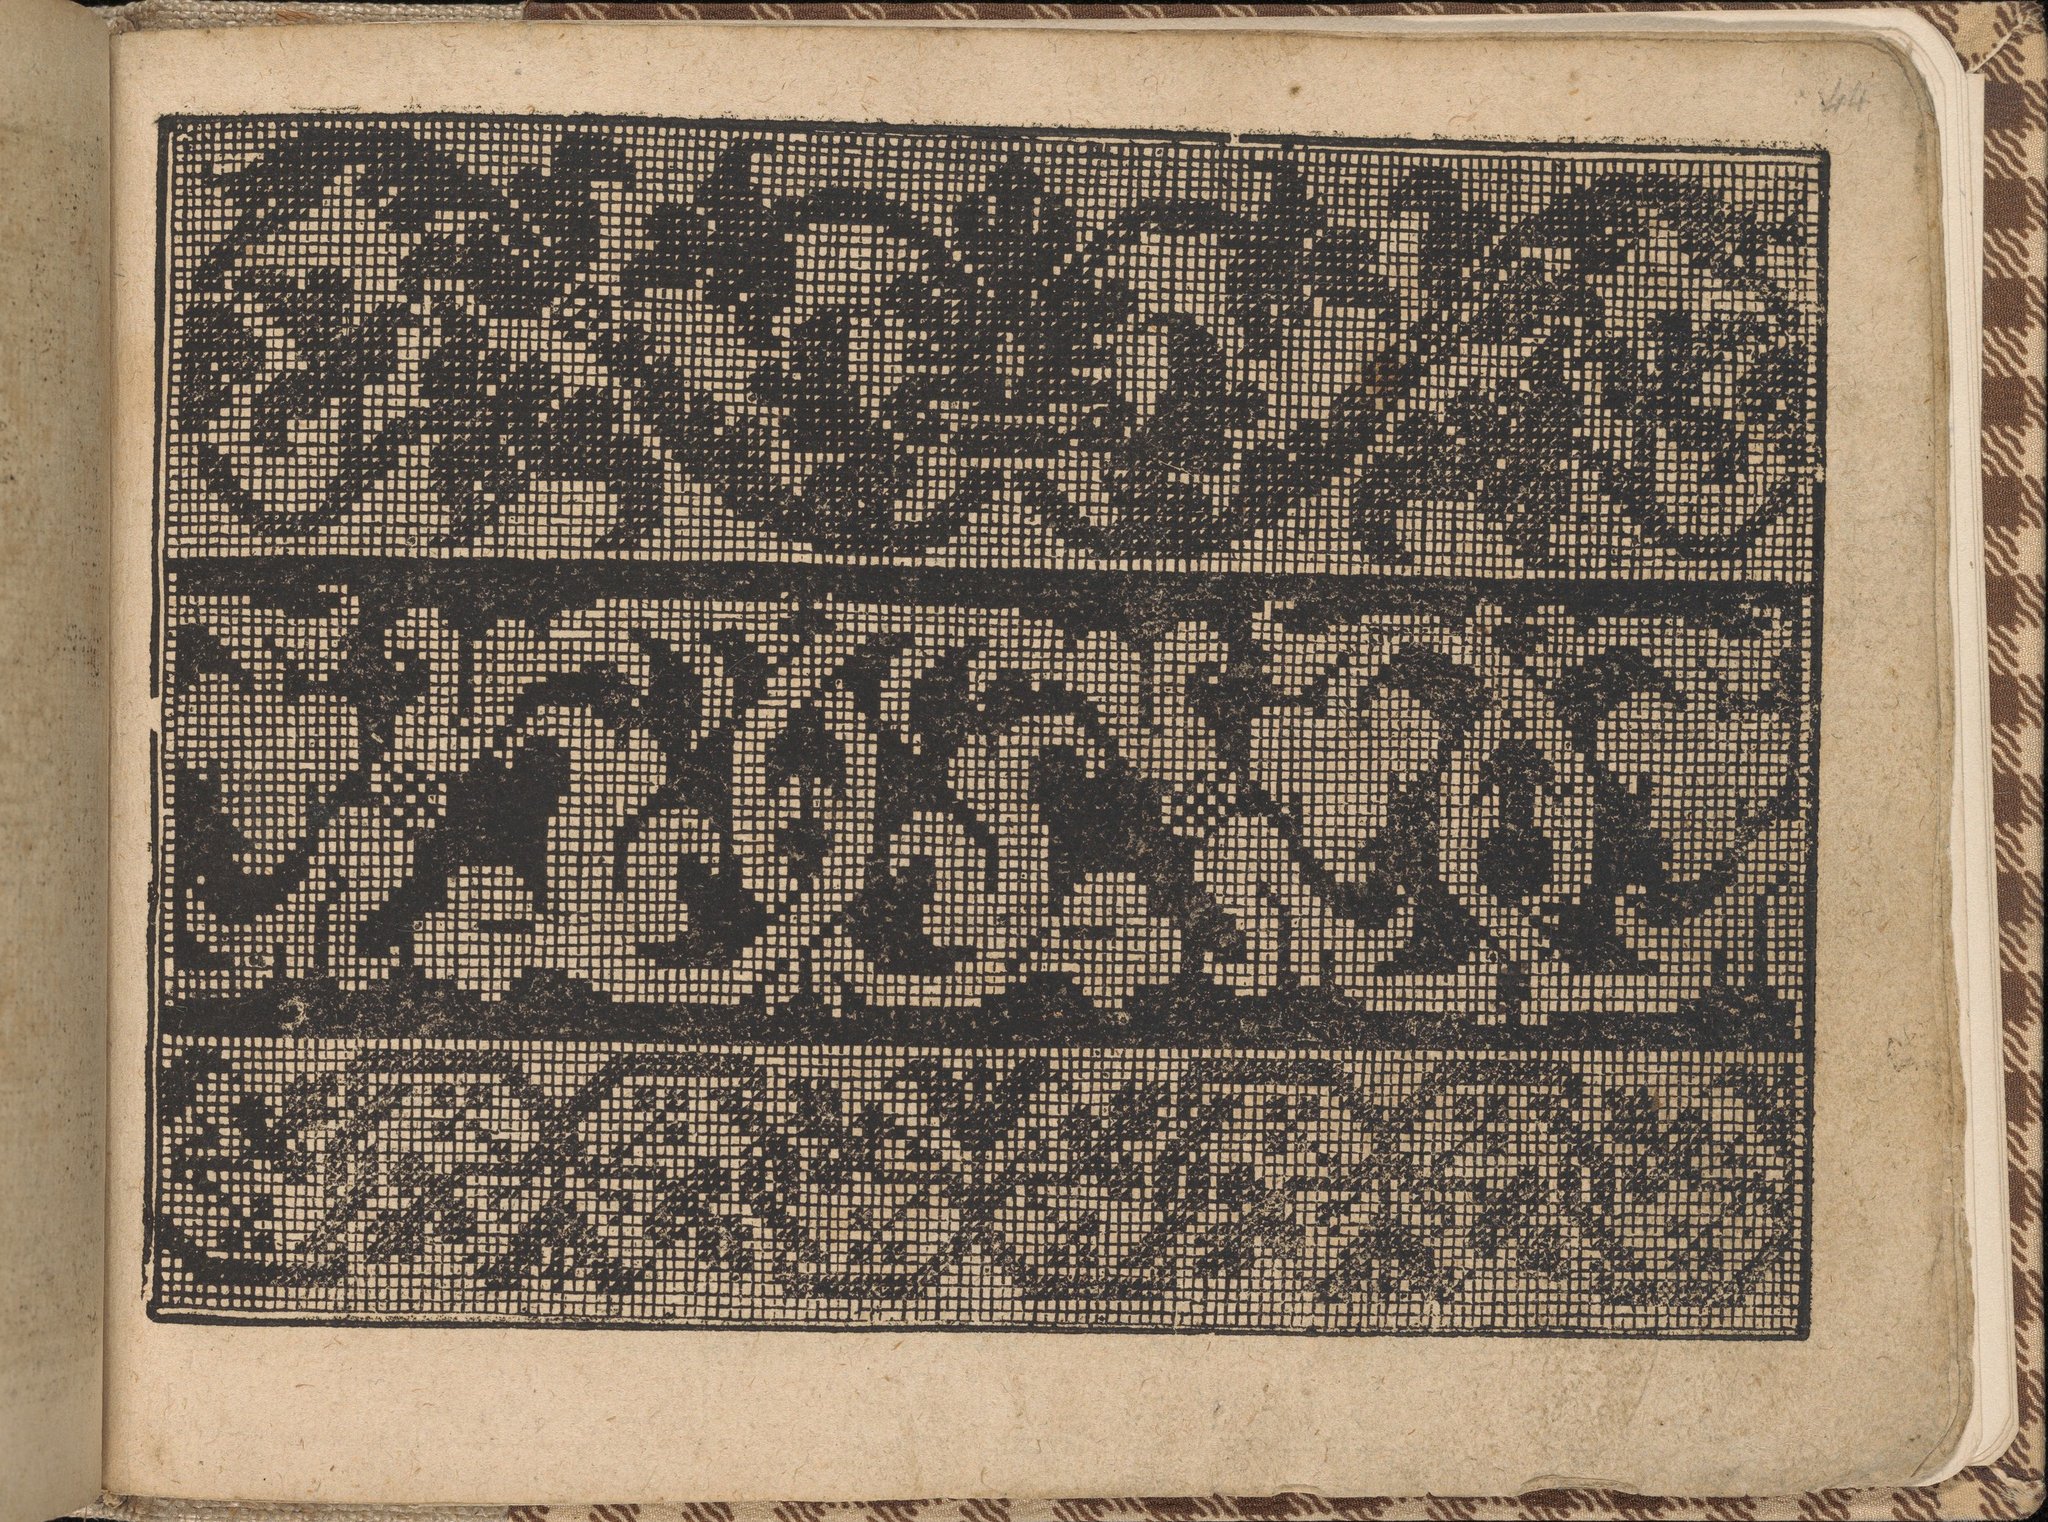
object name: book print ornament architecture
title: New Künstlichs Modelbuch (Page 44 recto)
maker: bernhard jobin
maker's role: publisher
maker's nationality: swiss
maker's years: 1535-1597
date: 1600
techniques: woodcut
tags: vines